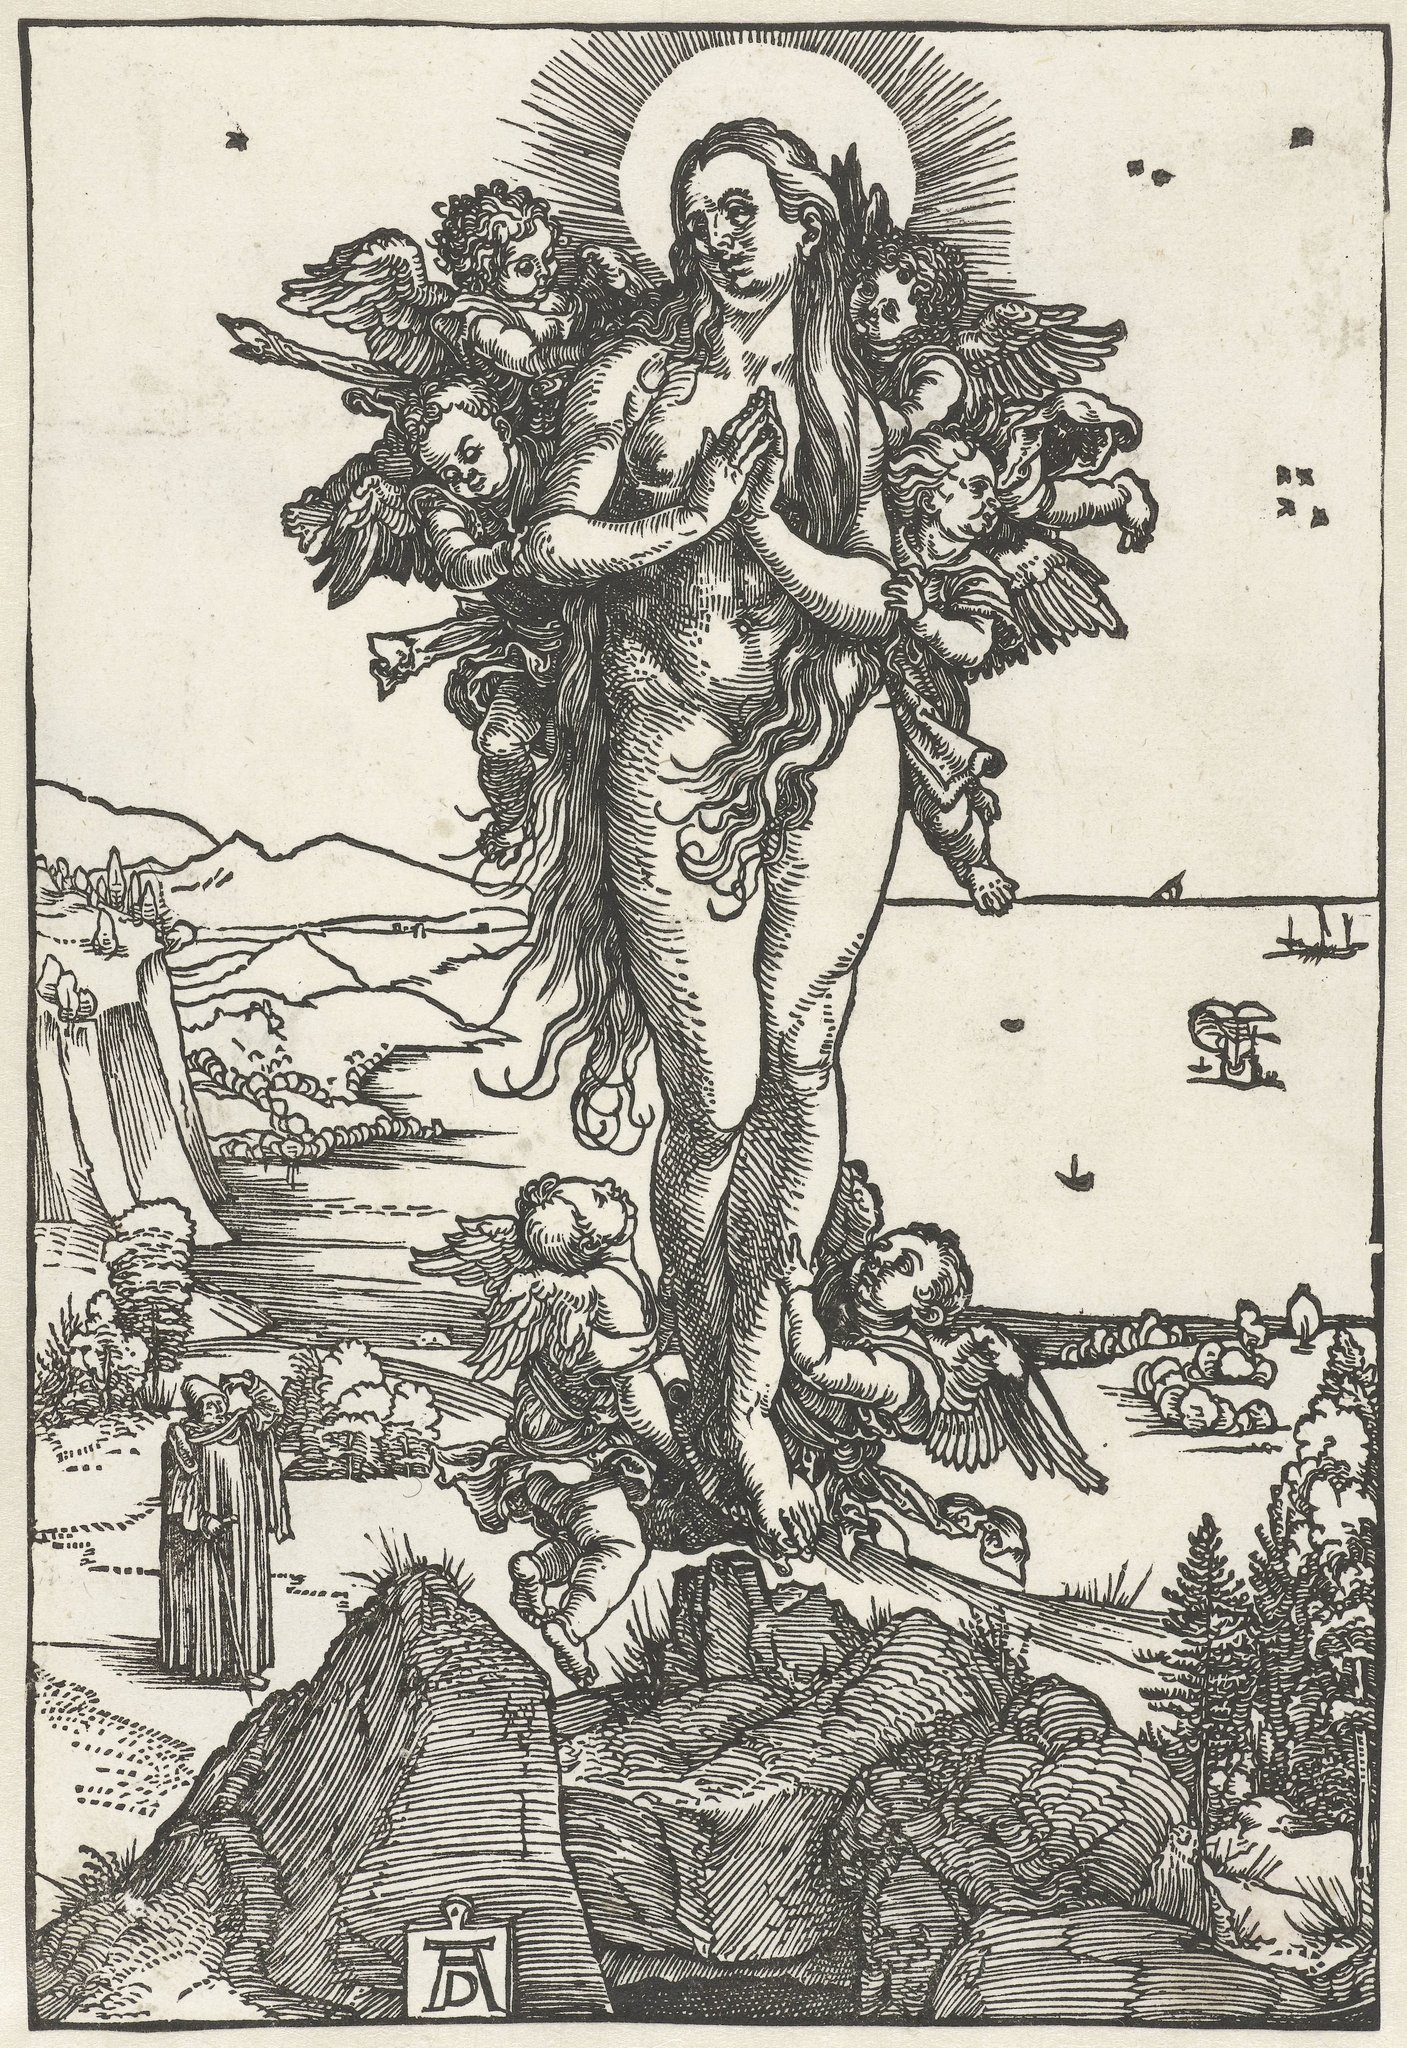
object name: print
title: De extase van Maria Magdalena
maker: albrecht dürer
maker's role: draughtsman, painter, print maker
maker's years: 1471-1528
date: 1504-1505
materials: paper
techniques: woodcut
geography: nuremberg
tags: the penitent harlot mary magdalene; possible attributes: book (or scroll), crown, crown of thorns, crucifix, jar of ointment, mirror, musical instrument, palm-branch, rosary, scourge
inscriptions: collector's mark: Lugt 240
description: Maria Magdalena wordt door engeltjes boven een kustlandschap gedragen. Op de achtergrond links een man die naar haar kijkt.